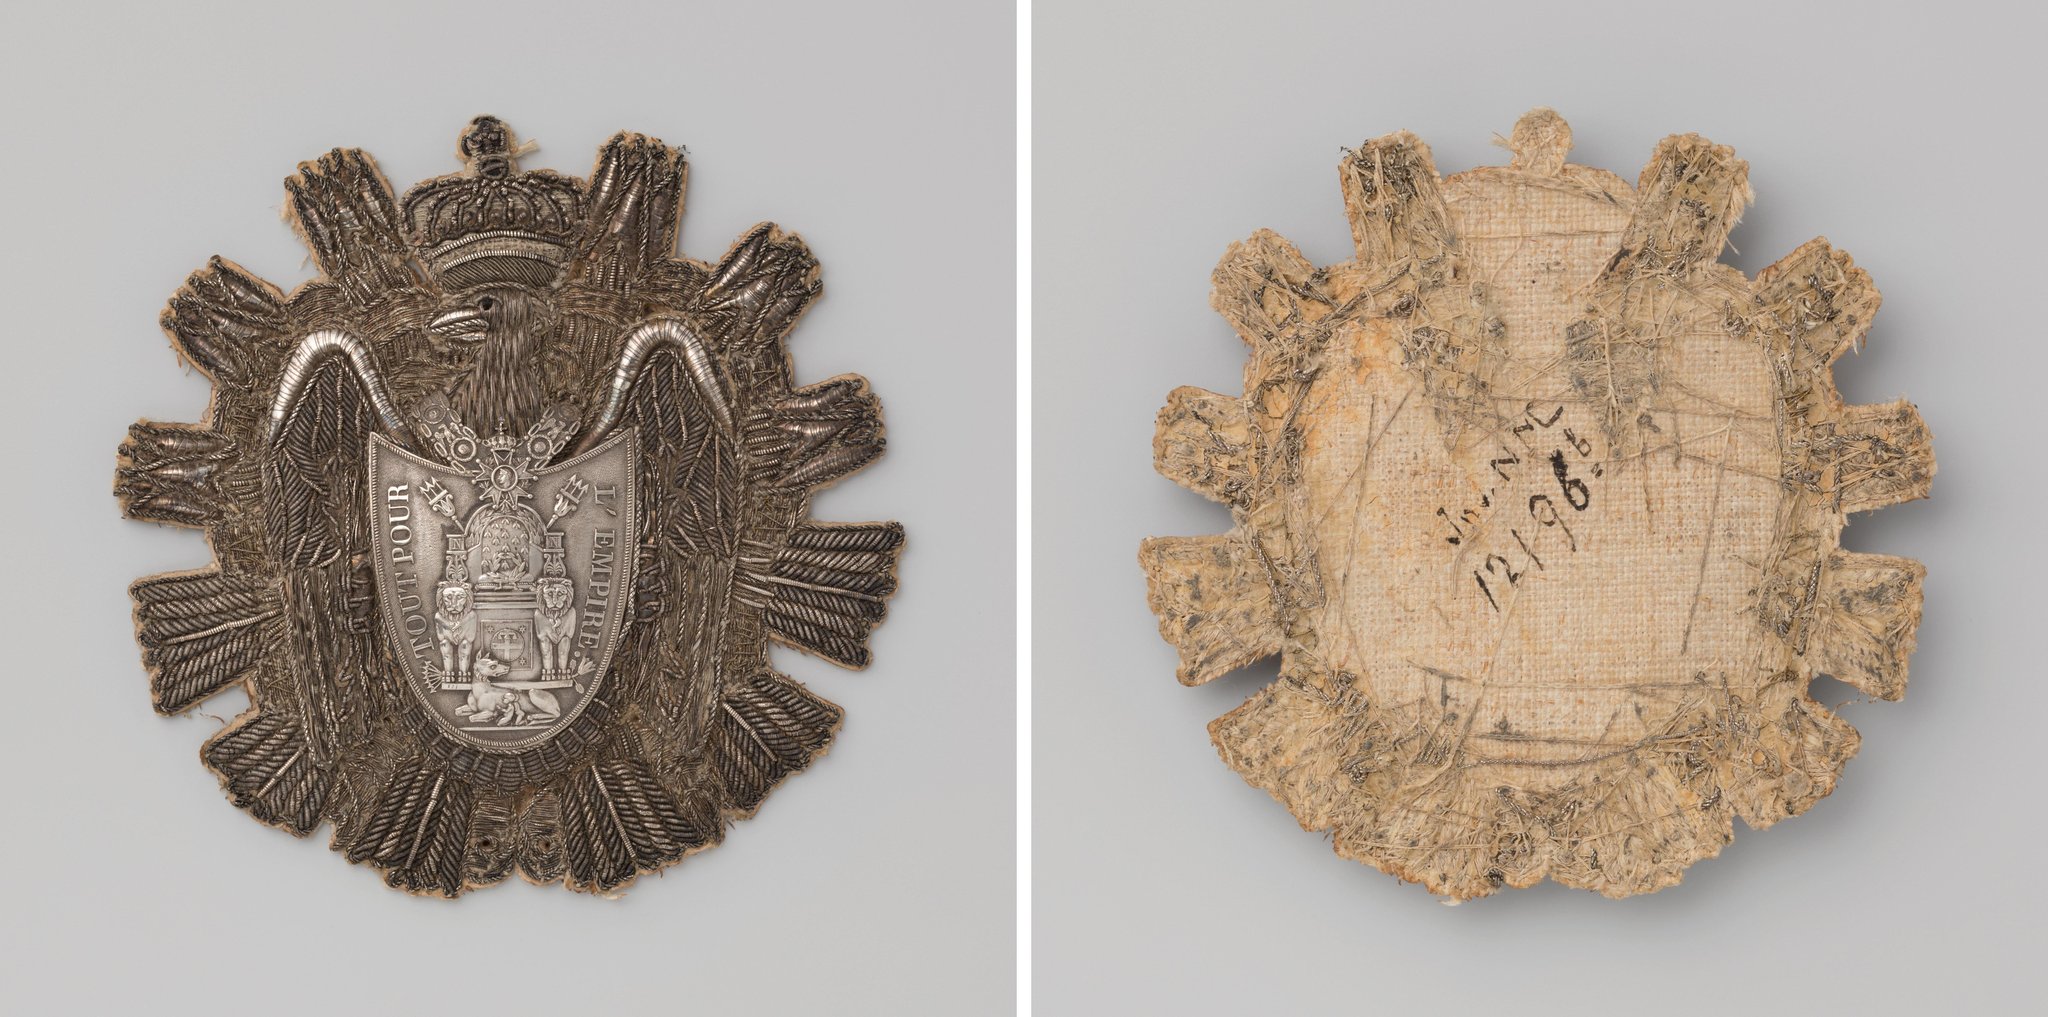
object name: insignia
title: Plaque van de Orde van de Reunie van I.J.A. Gogel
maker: Anonymous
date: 1811-1815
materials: copper, linen, silver, thread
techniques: embroidered, silvering, stitching, striking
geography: france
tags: napoleon i (emperor of the french)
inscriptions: inscription: ‘TOUT POUR’, edge inscription: ‘A JAMAIS’, inscription: ‘L'EMPIRE’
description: Decorations and medals, 1806-1813. King Louis Napoleon instituted two national orders: the Order of Merit, with the motto 'do well and do not look back', and the Order of the Union, with the motto 'luctor et emergo'. A year later the two orders were merged to form the Royal Order of Holland, renamed the Royal Order of the Union after 1808. Instead of the king's head, the medal showed a bundle of arrows. When the Netherlands was annexed by France in 1810, Emperor Napoleon introduced the Order of Reunion to replace the Order of the Union. These decorations were originally awarded to I.J.A. Gogel, who served for many years as minister of finance.